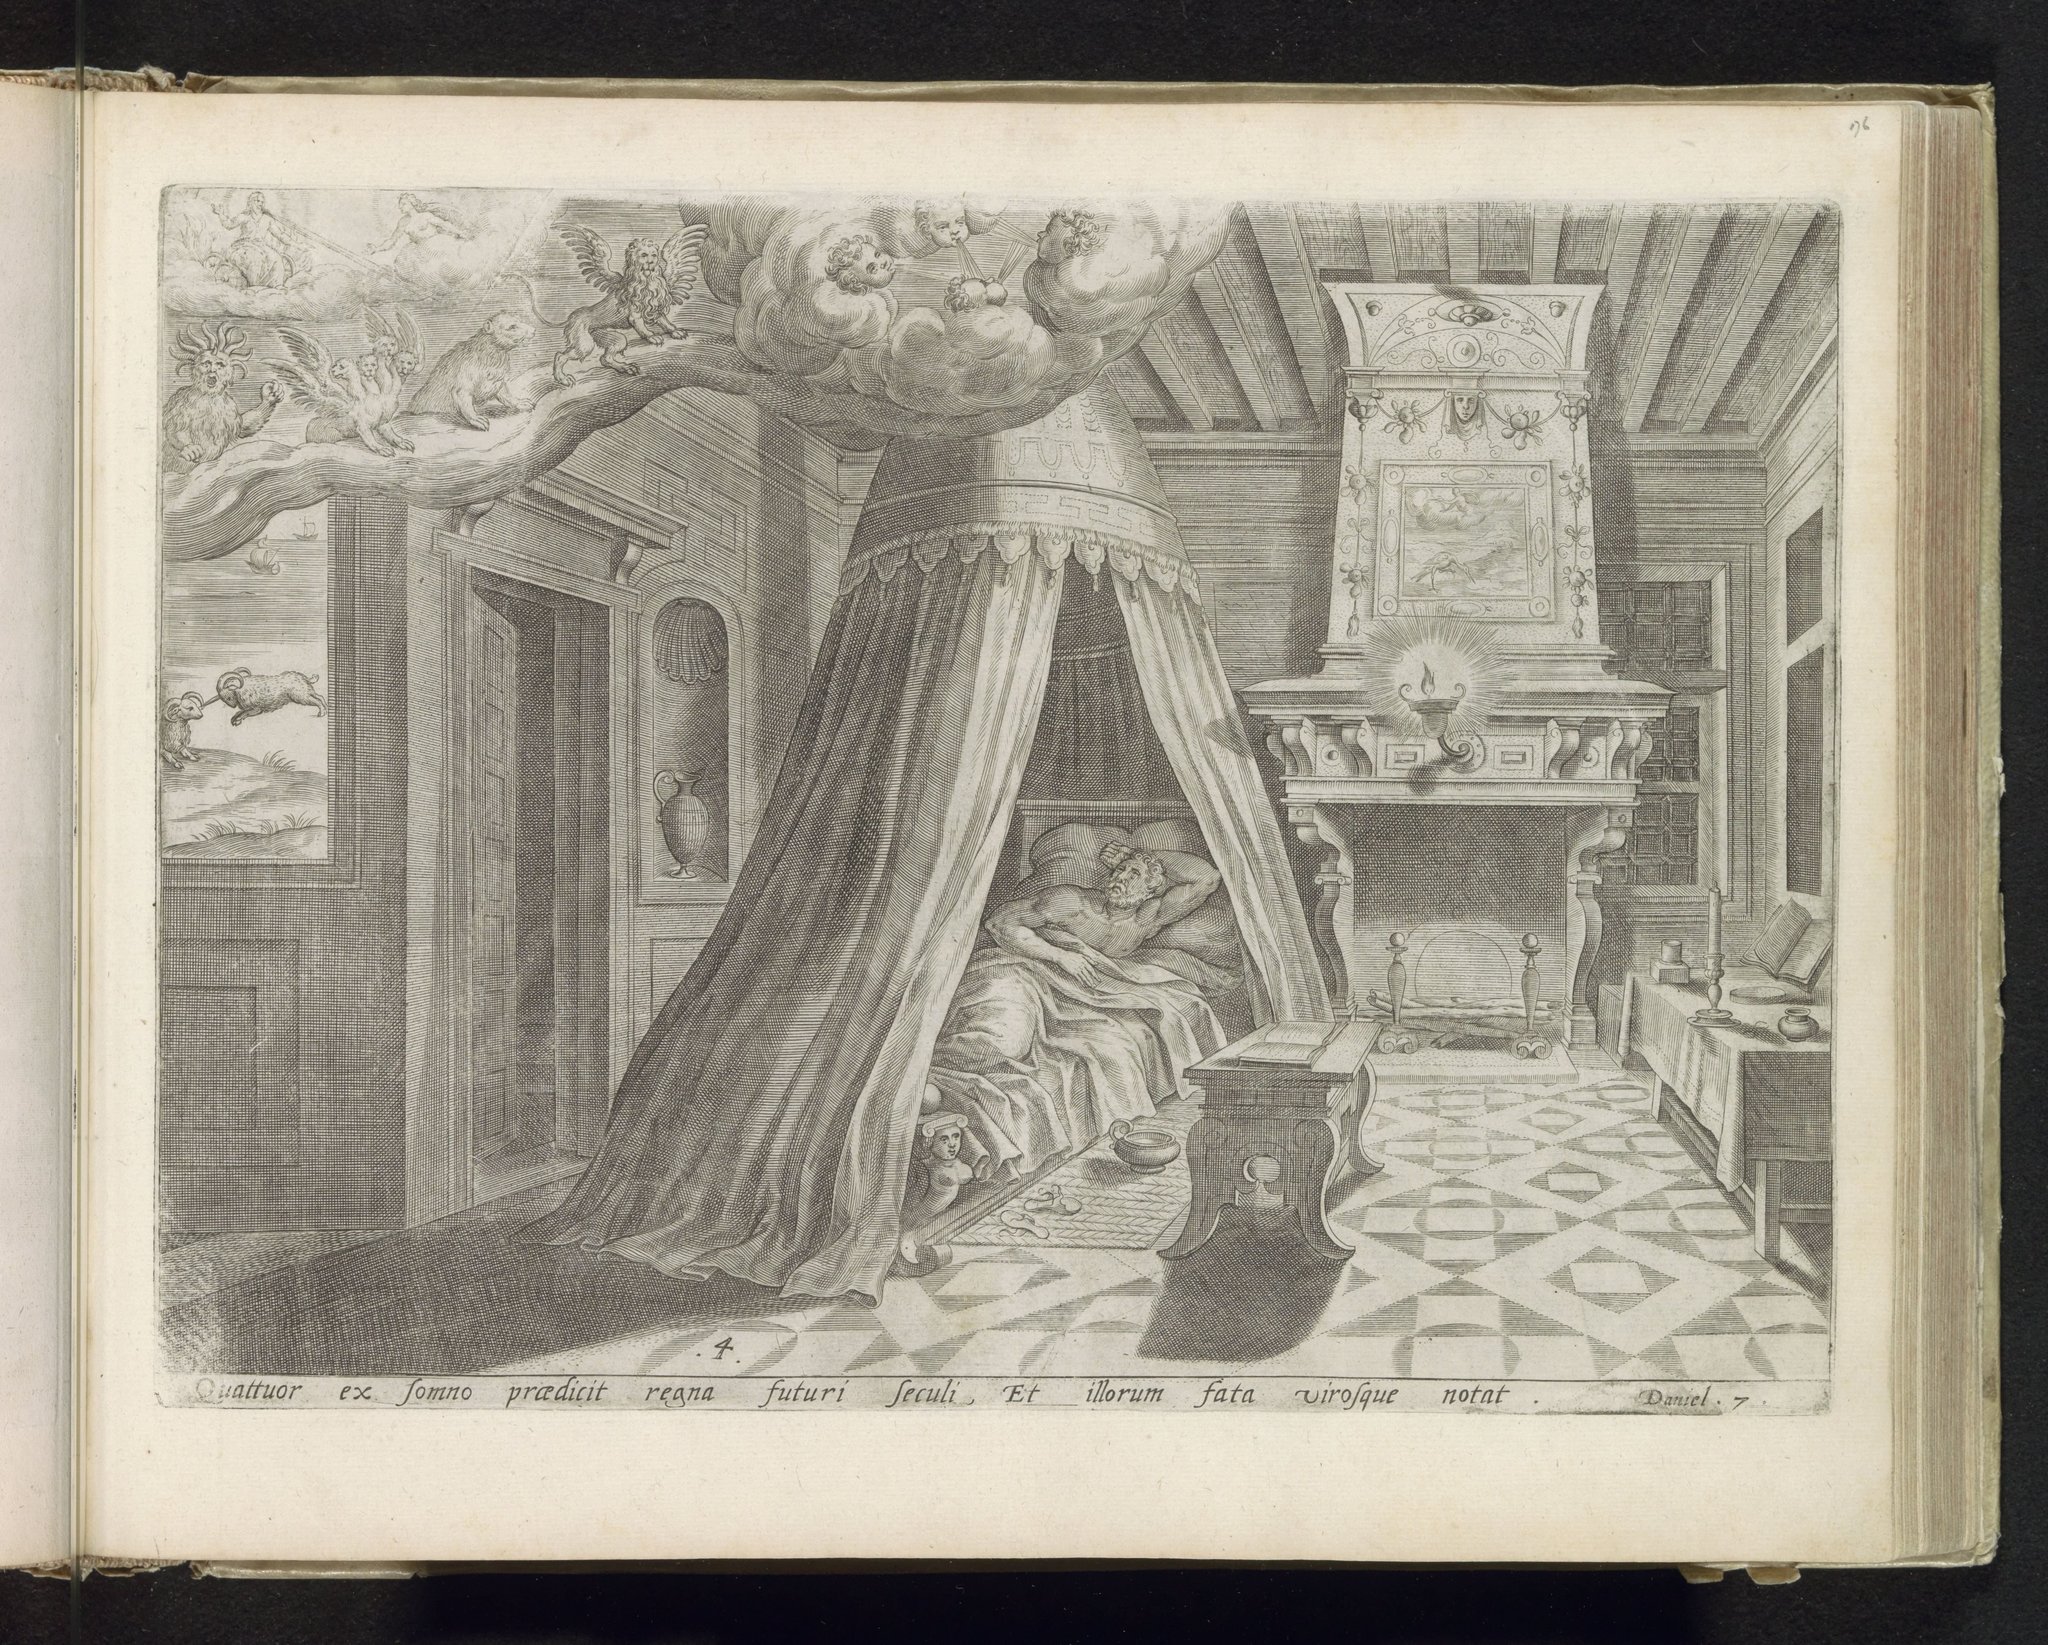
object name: print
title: Daniëls droom van de vier dieren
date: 1585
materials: paper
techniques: engraving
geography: antwerp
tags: four great beasts rising from the sea ~ daniel's visions, the he-goat fights with the ram and slays it ~ daniel's visions, the ancient of days, in white robes, on a fiery throne ~ daniel's visions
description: Daniël ligt in een bed onder een baldakijn te slapen en droomt. Linksboven zijn droom van de vier dieren: een gevleugelde leeuw, een beer, een vierkoppige panter en een dier met tien horens. Daarboven de oude wijze. In het landschap links zijn visioen van de ram en de geitenbok. Onder de voorstelling een verwijzing in het Latijn naar de Bijbeltekst in Dan. 7. Deze prent maakt deel uit van een album.